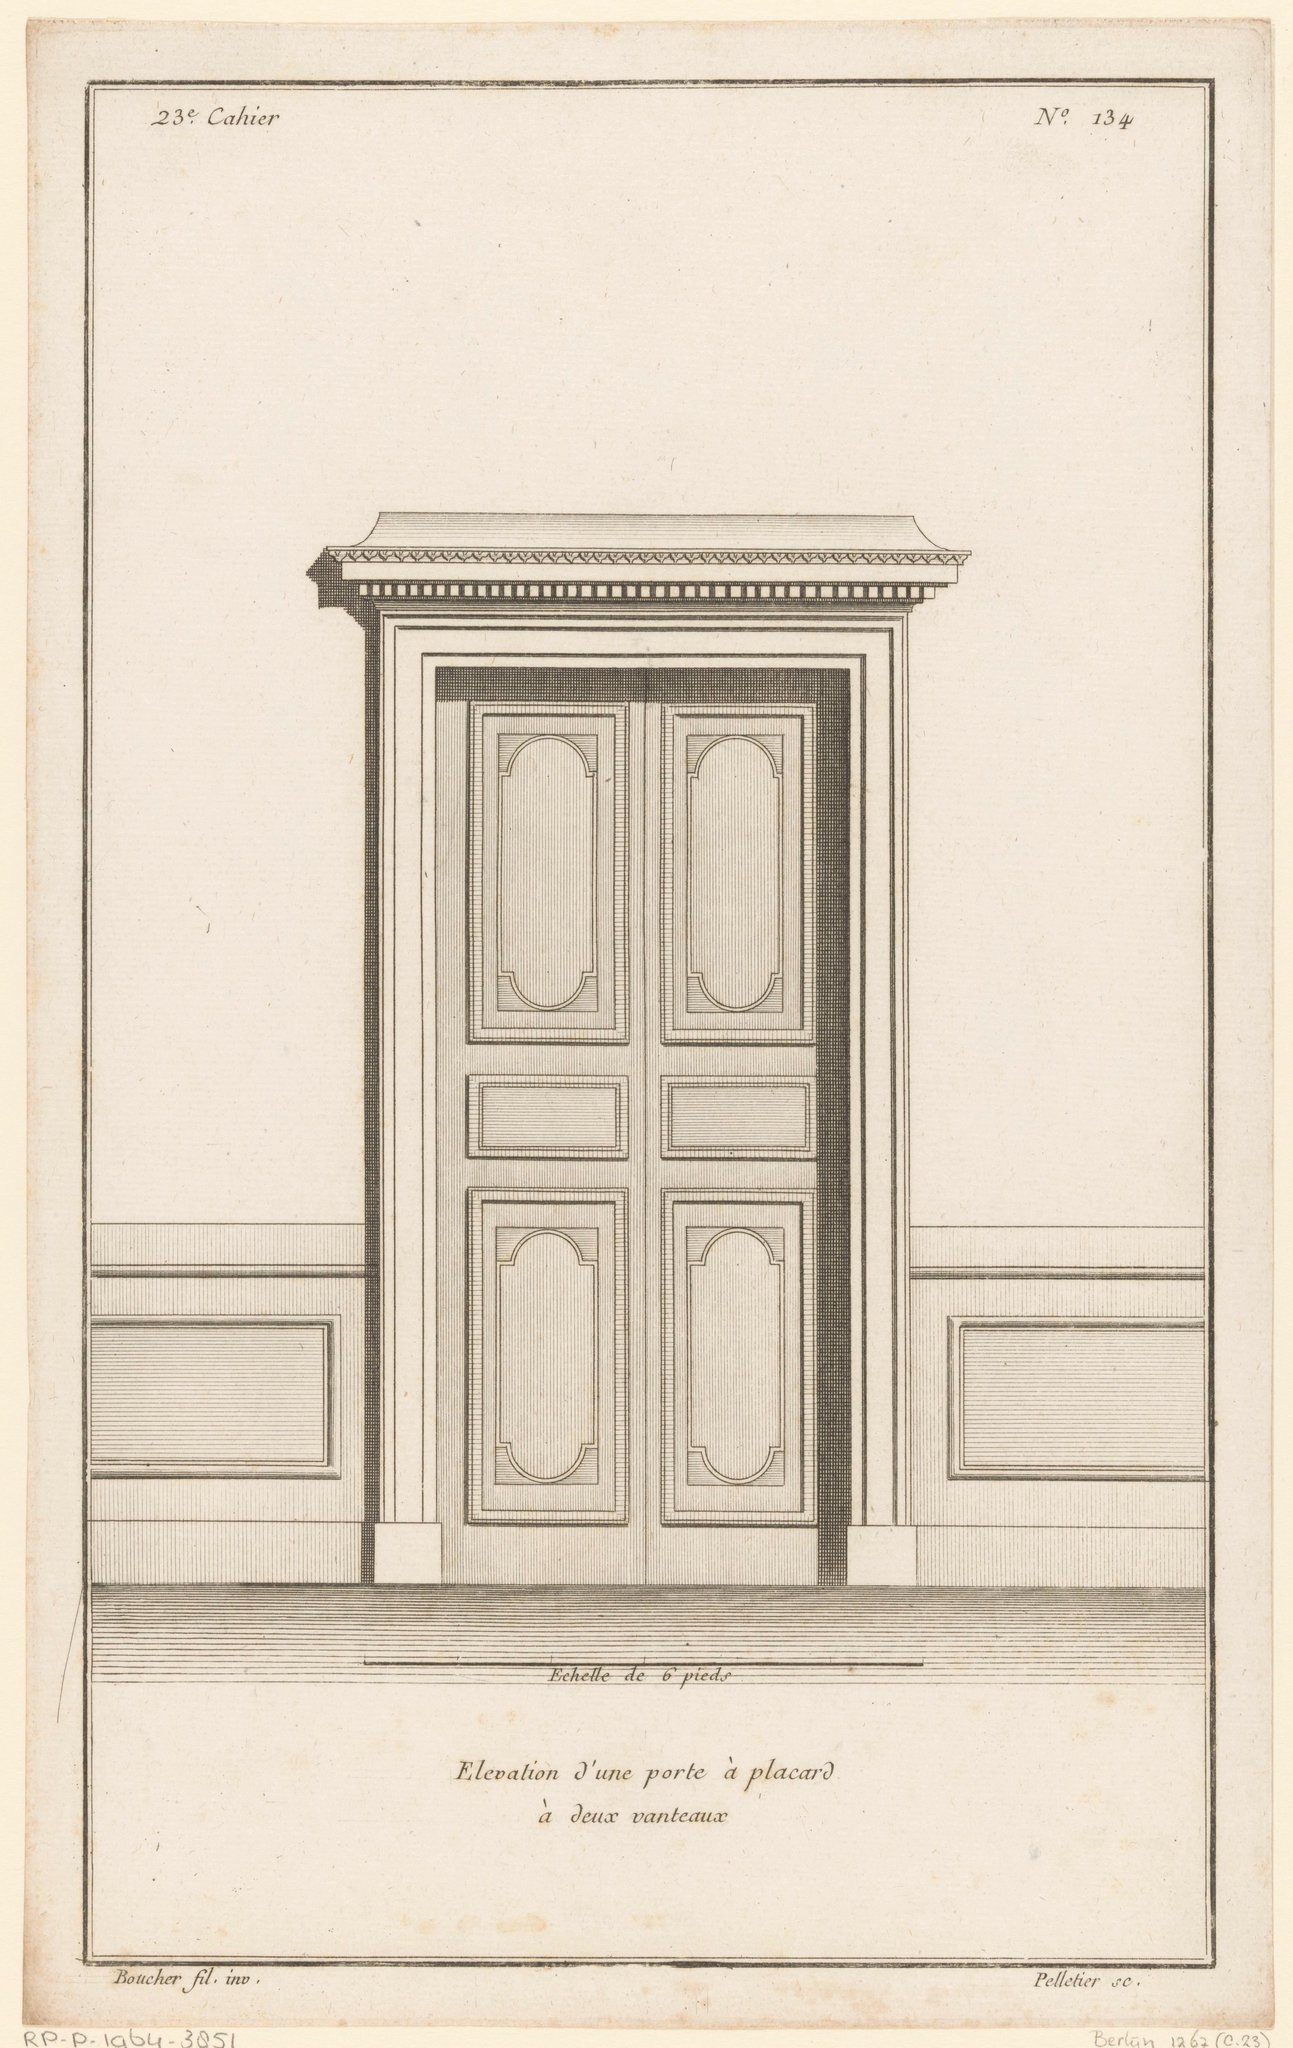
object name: print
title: Elevation d'une porte à placard à deux vanteaux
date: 1772-1779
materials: paper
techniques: engraving, etching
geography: paris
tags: door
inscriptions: collector's mark: Lugt 2760, collector's mark: Lugt 2228